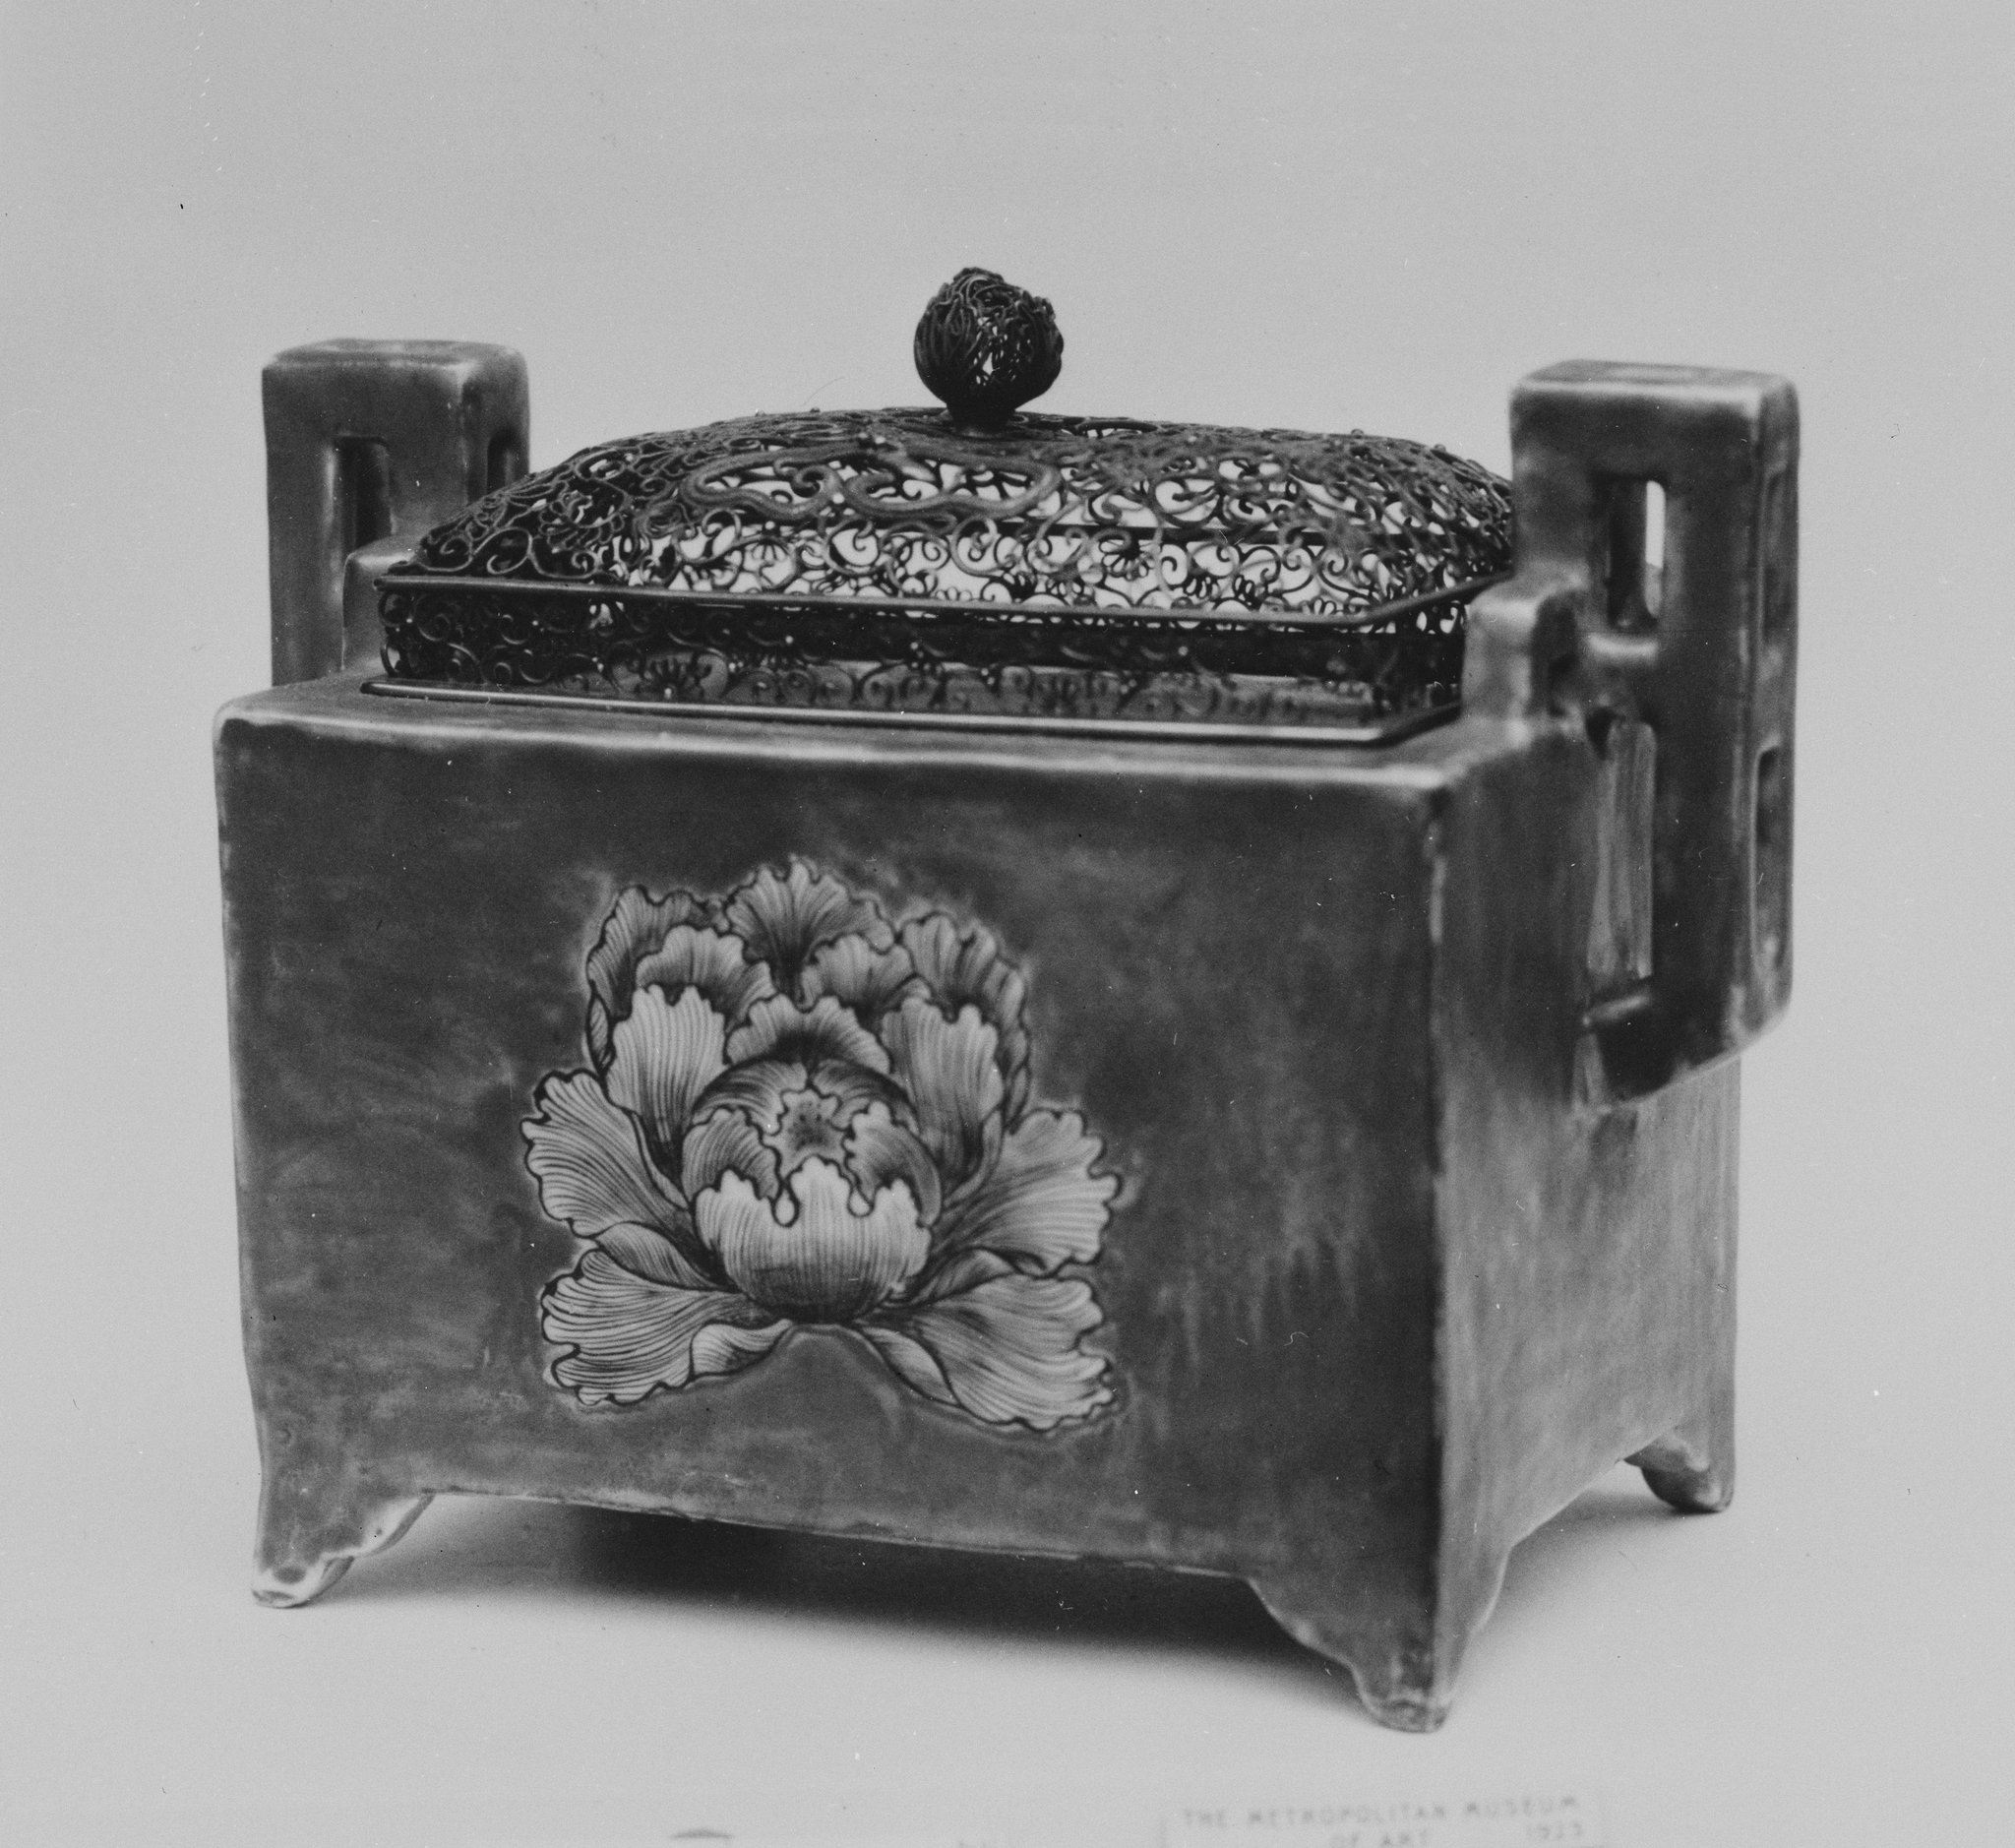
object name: censer with cover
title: Censer and cover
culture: japanese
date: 1800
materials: enamel, porcelain, silver